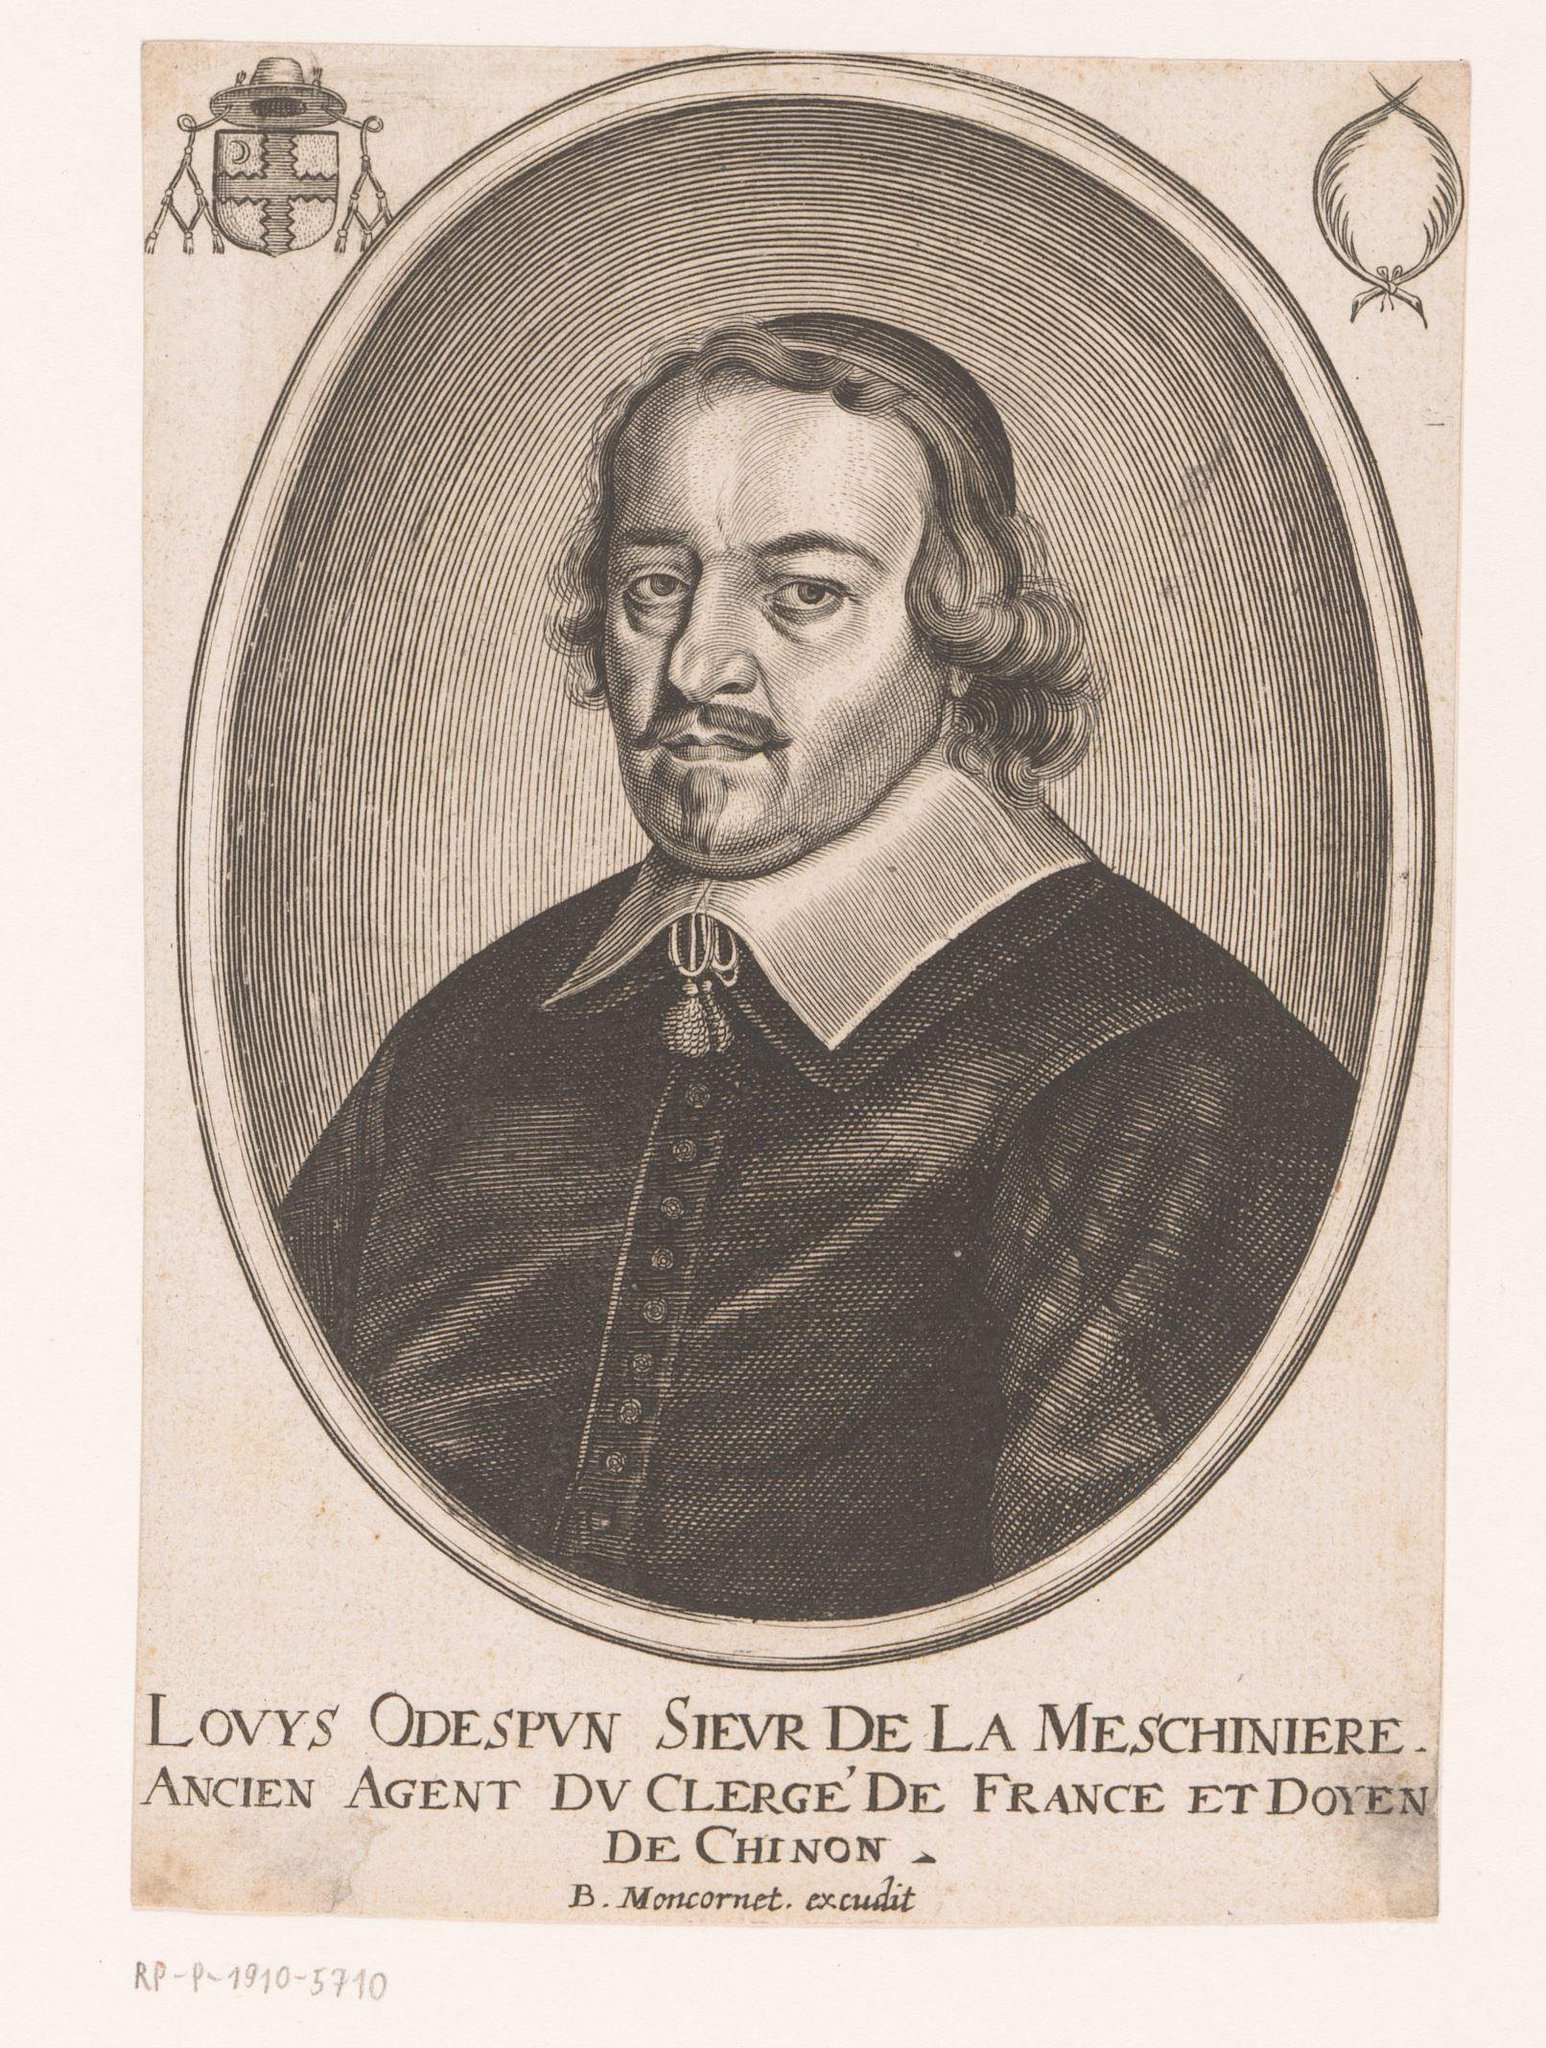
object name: print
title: Portret van Louis Odespung de La Meschinière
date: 1637-1668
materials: paper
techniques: engraving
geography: paris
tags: historical persons, art collector, armorial bearing, heraldry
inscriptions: collector's mark: Lugt 2228